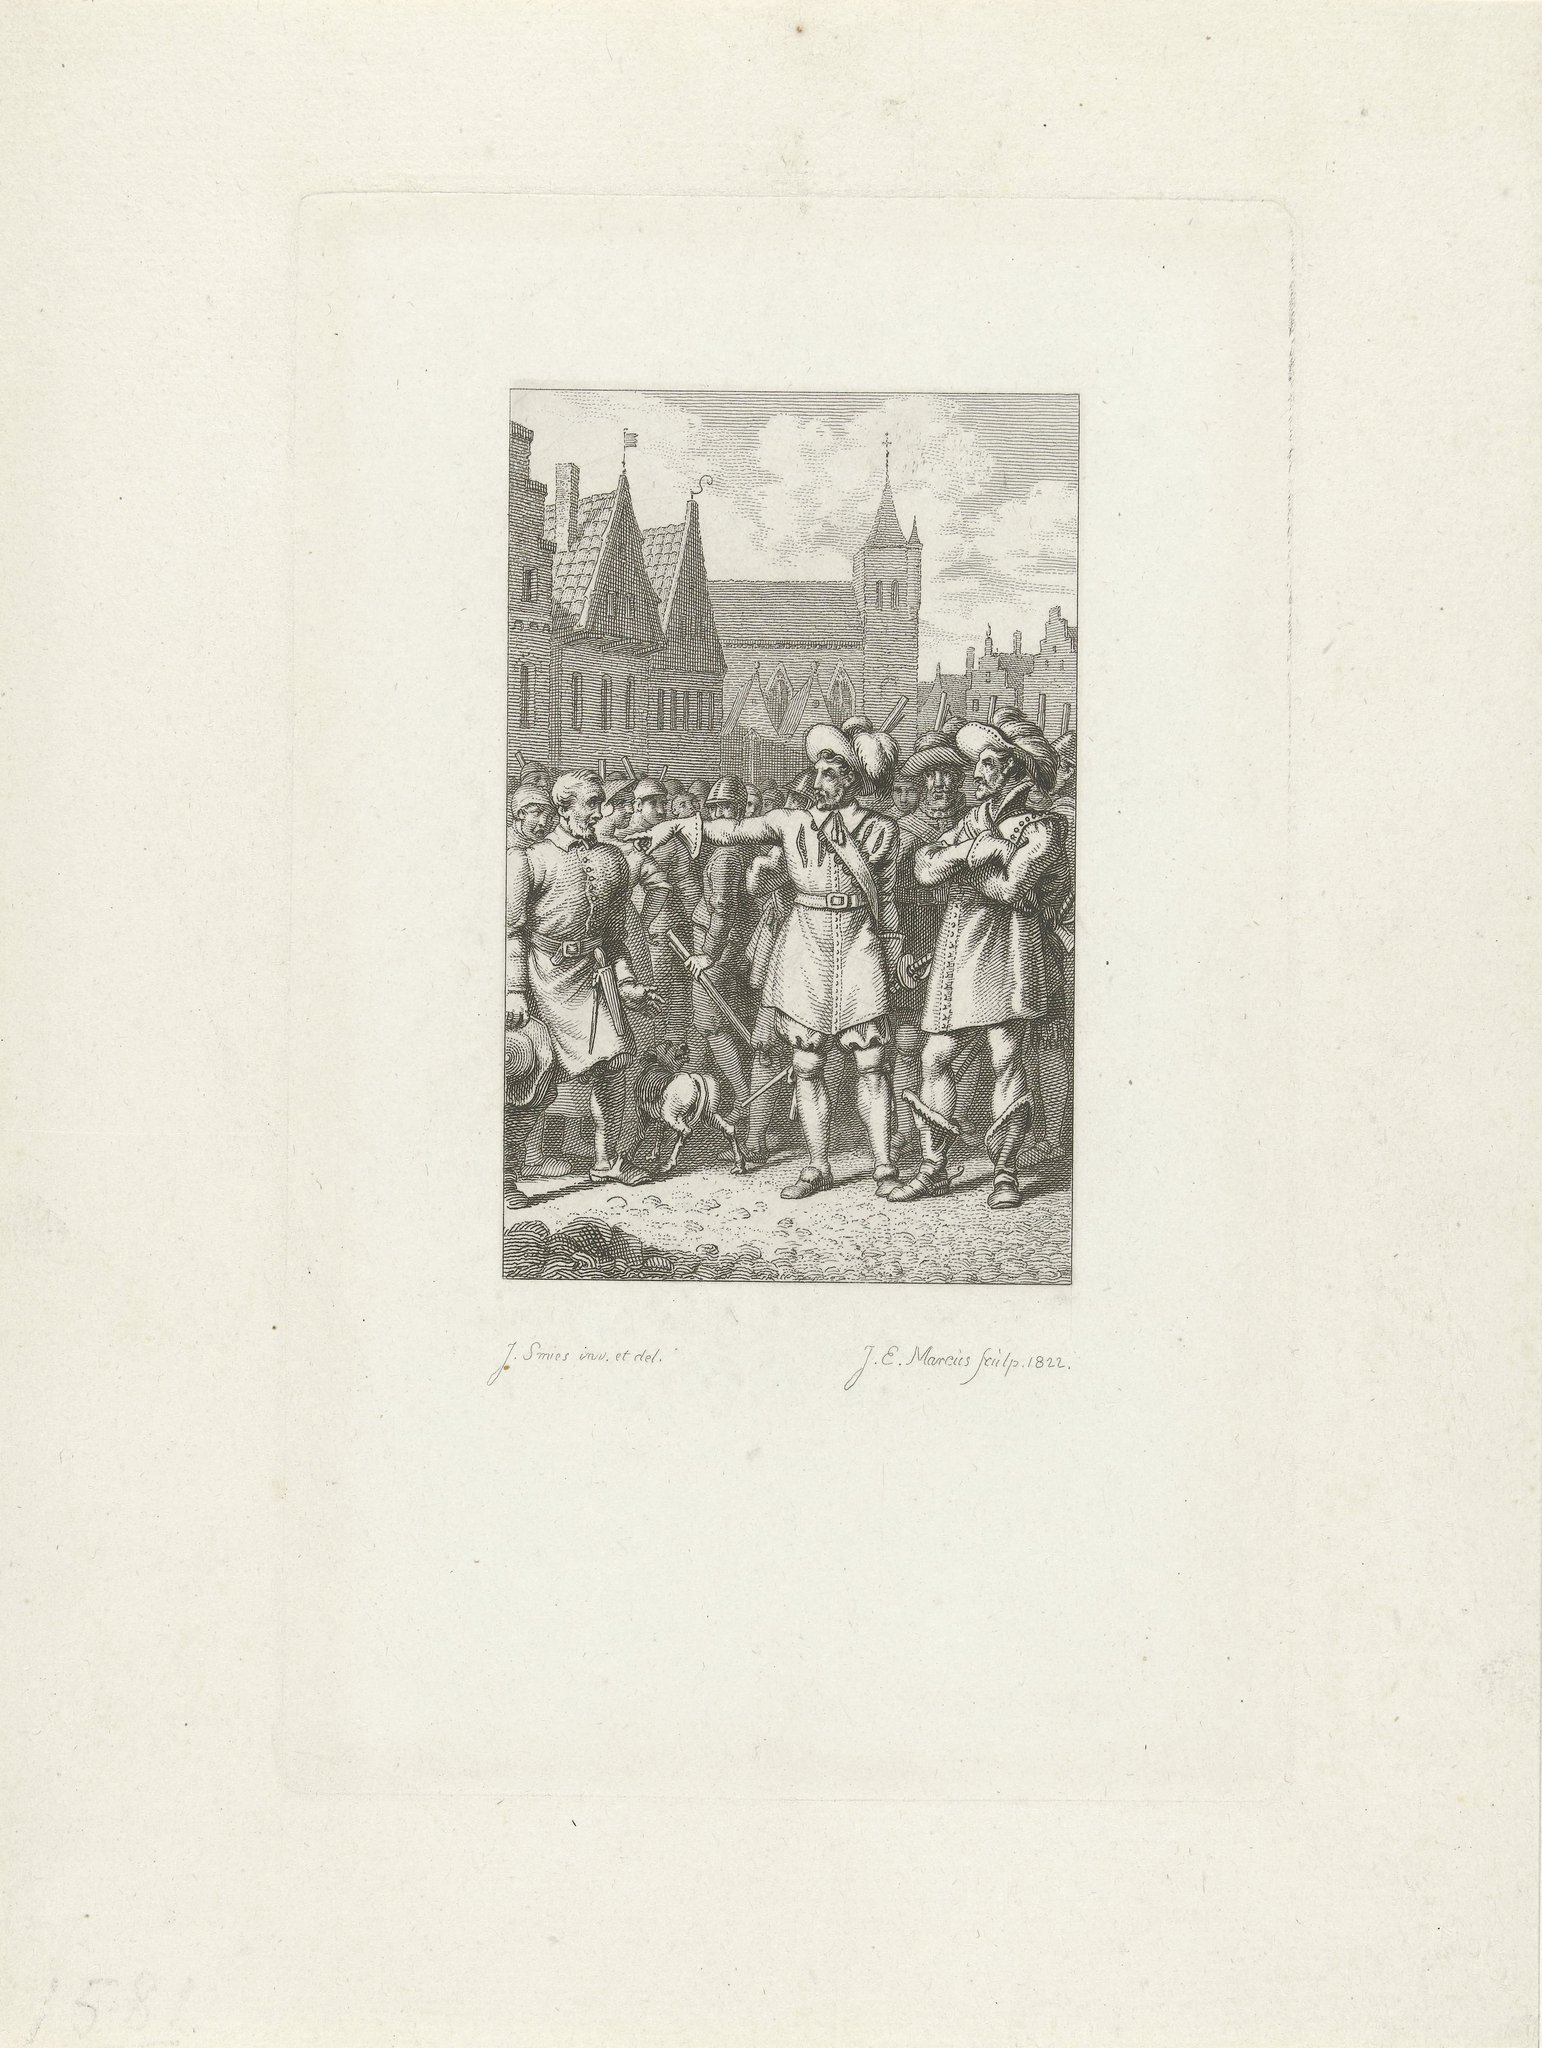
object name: print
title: Flinke taal van Kornput te Steenwijk, 1581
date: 1822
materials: paper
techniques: etching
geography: netherlands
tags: johan van den kornput, steenwijk, tachtigjarige oorlog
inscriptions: date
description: Illustratie voor: P.C. Hoofts Nederlandsche historien / met aanteekn. en ophelderingen van M. Siegenbeek, A. Simons en J.P. van Cappelle. J. van der Hey, Amsterdam 1820-1824.